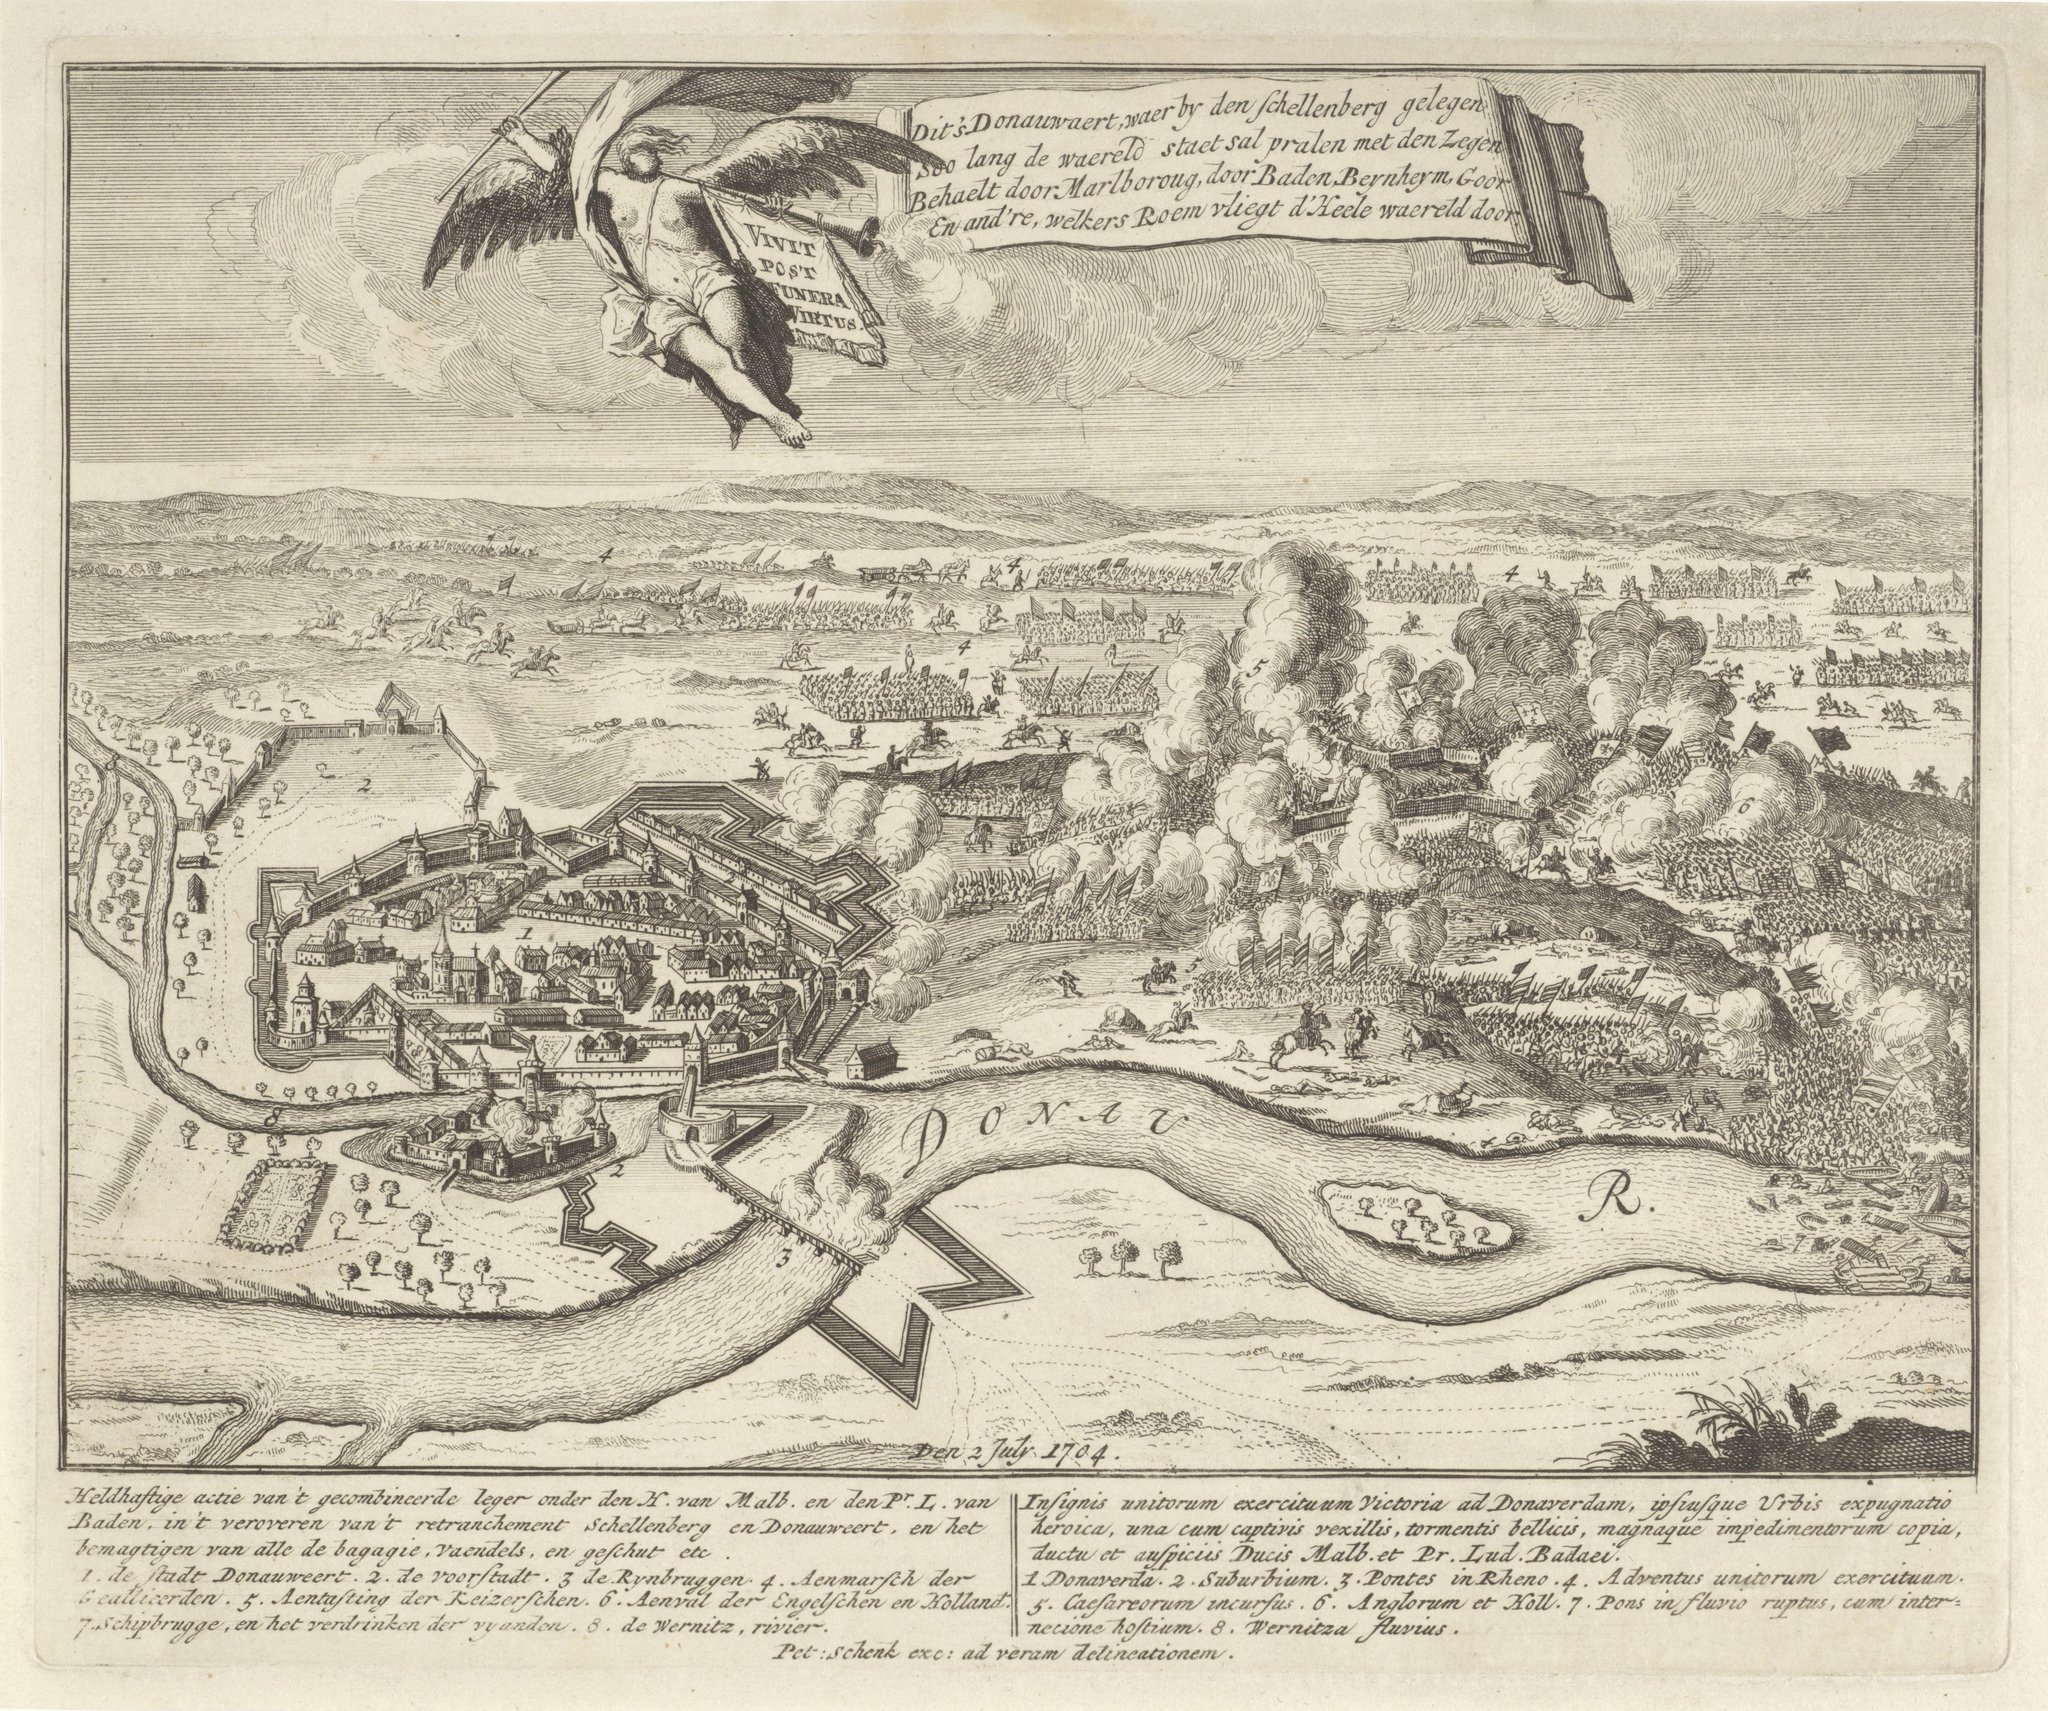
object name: print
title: Gevecht bij Donauwörth, 1704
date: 1704-1711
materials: paper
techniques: etching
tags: maps of separate countries or regions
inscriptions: collector's mark: Lugt 2228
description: Kaart met de gevechten bij Donauwörth tussen de Geallieerden en de Beiersen en Fransen, 2 juli 1704.